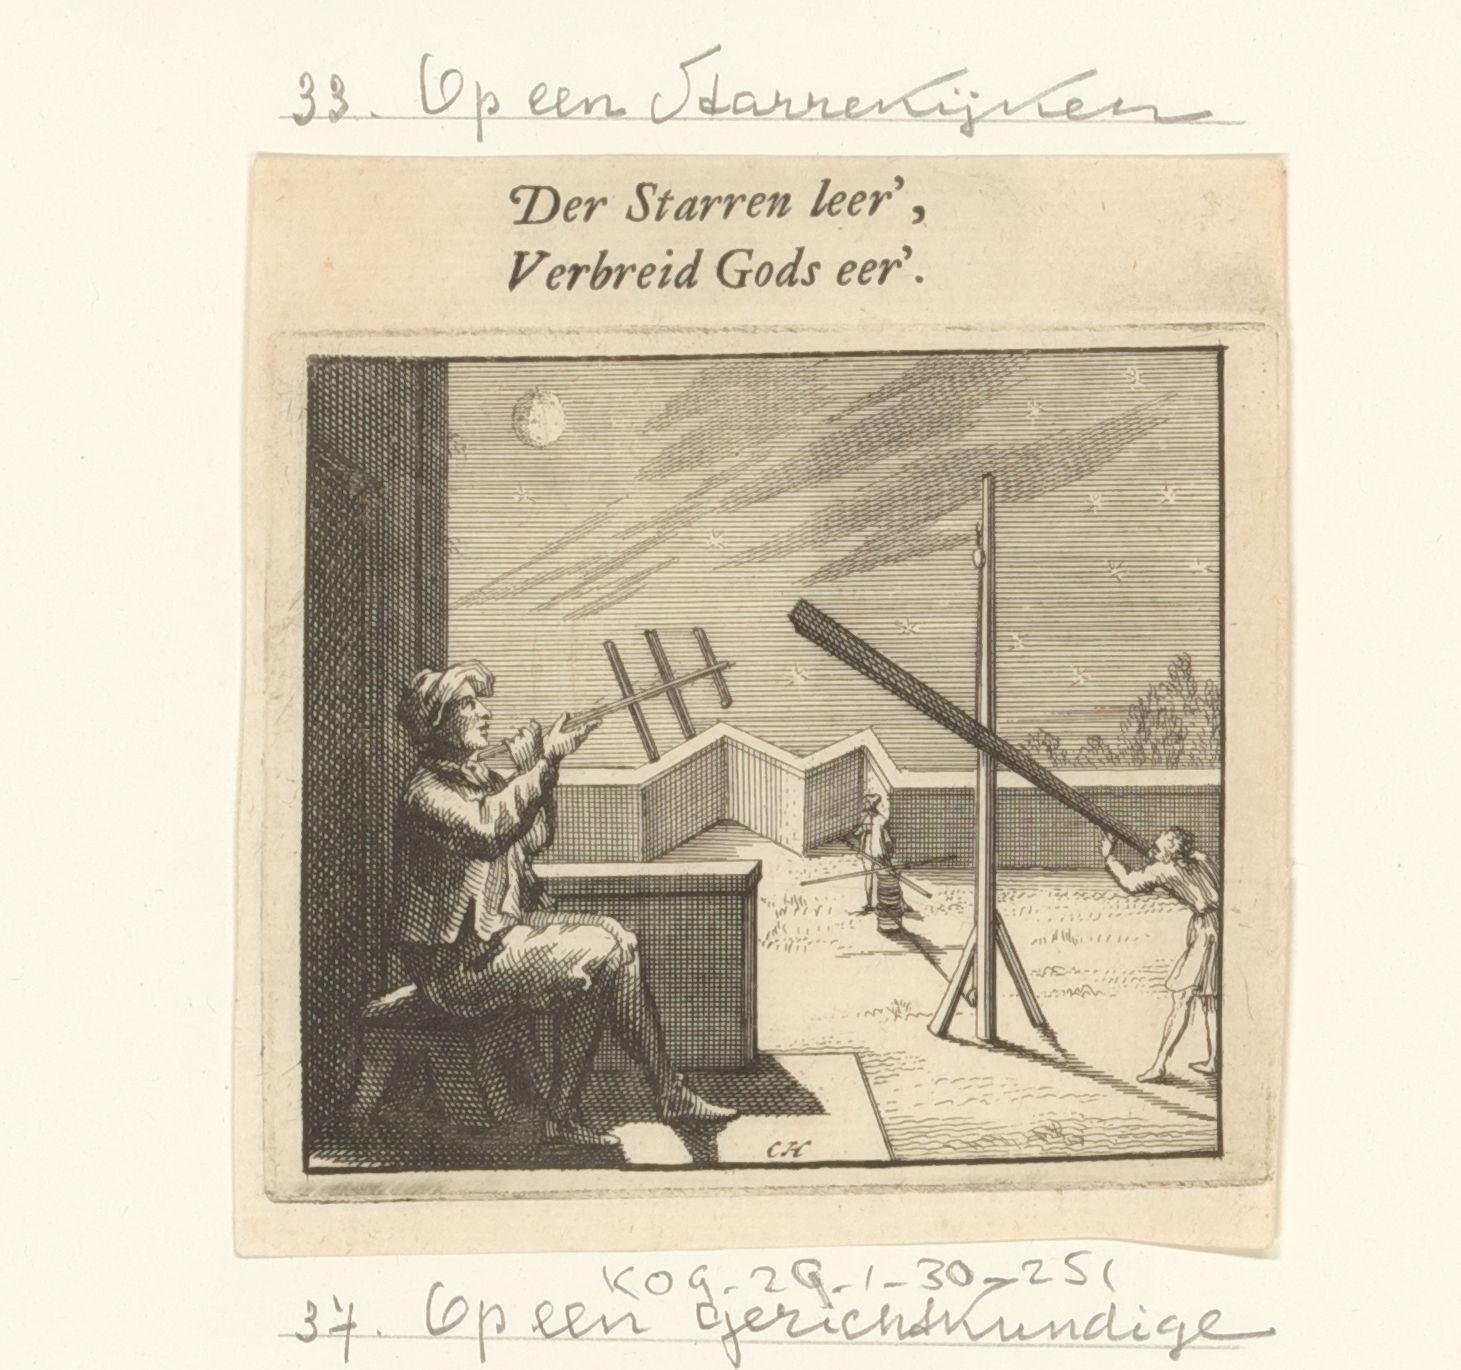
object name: print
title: Der Starren leer', Verbreid Gods eer'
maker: cornelis huyberts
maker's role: print maker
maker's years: 1669-1709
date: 1725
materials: paper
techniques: etching, letterpress printing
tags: astronomical instruments, stars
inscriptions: stamp, collector's mark: Lugt 1641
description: Prent uit: Graauwhart, Hendrik. Voorbeeldelyke zeede-lessen, genoomen uyt den eersten toestand des werelds (...). Amsterdam: Johannes Ratelband, 1725. Prent ook gebruikt voor eerdere en (1709) latere uitgave (1756, 1761 en 1764).